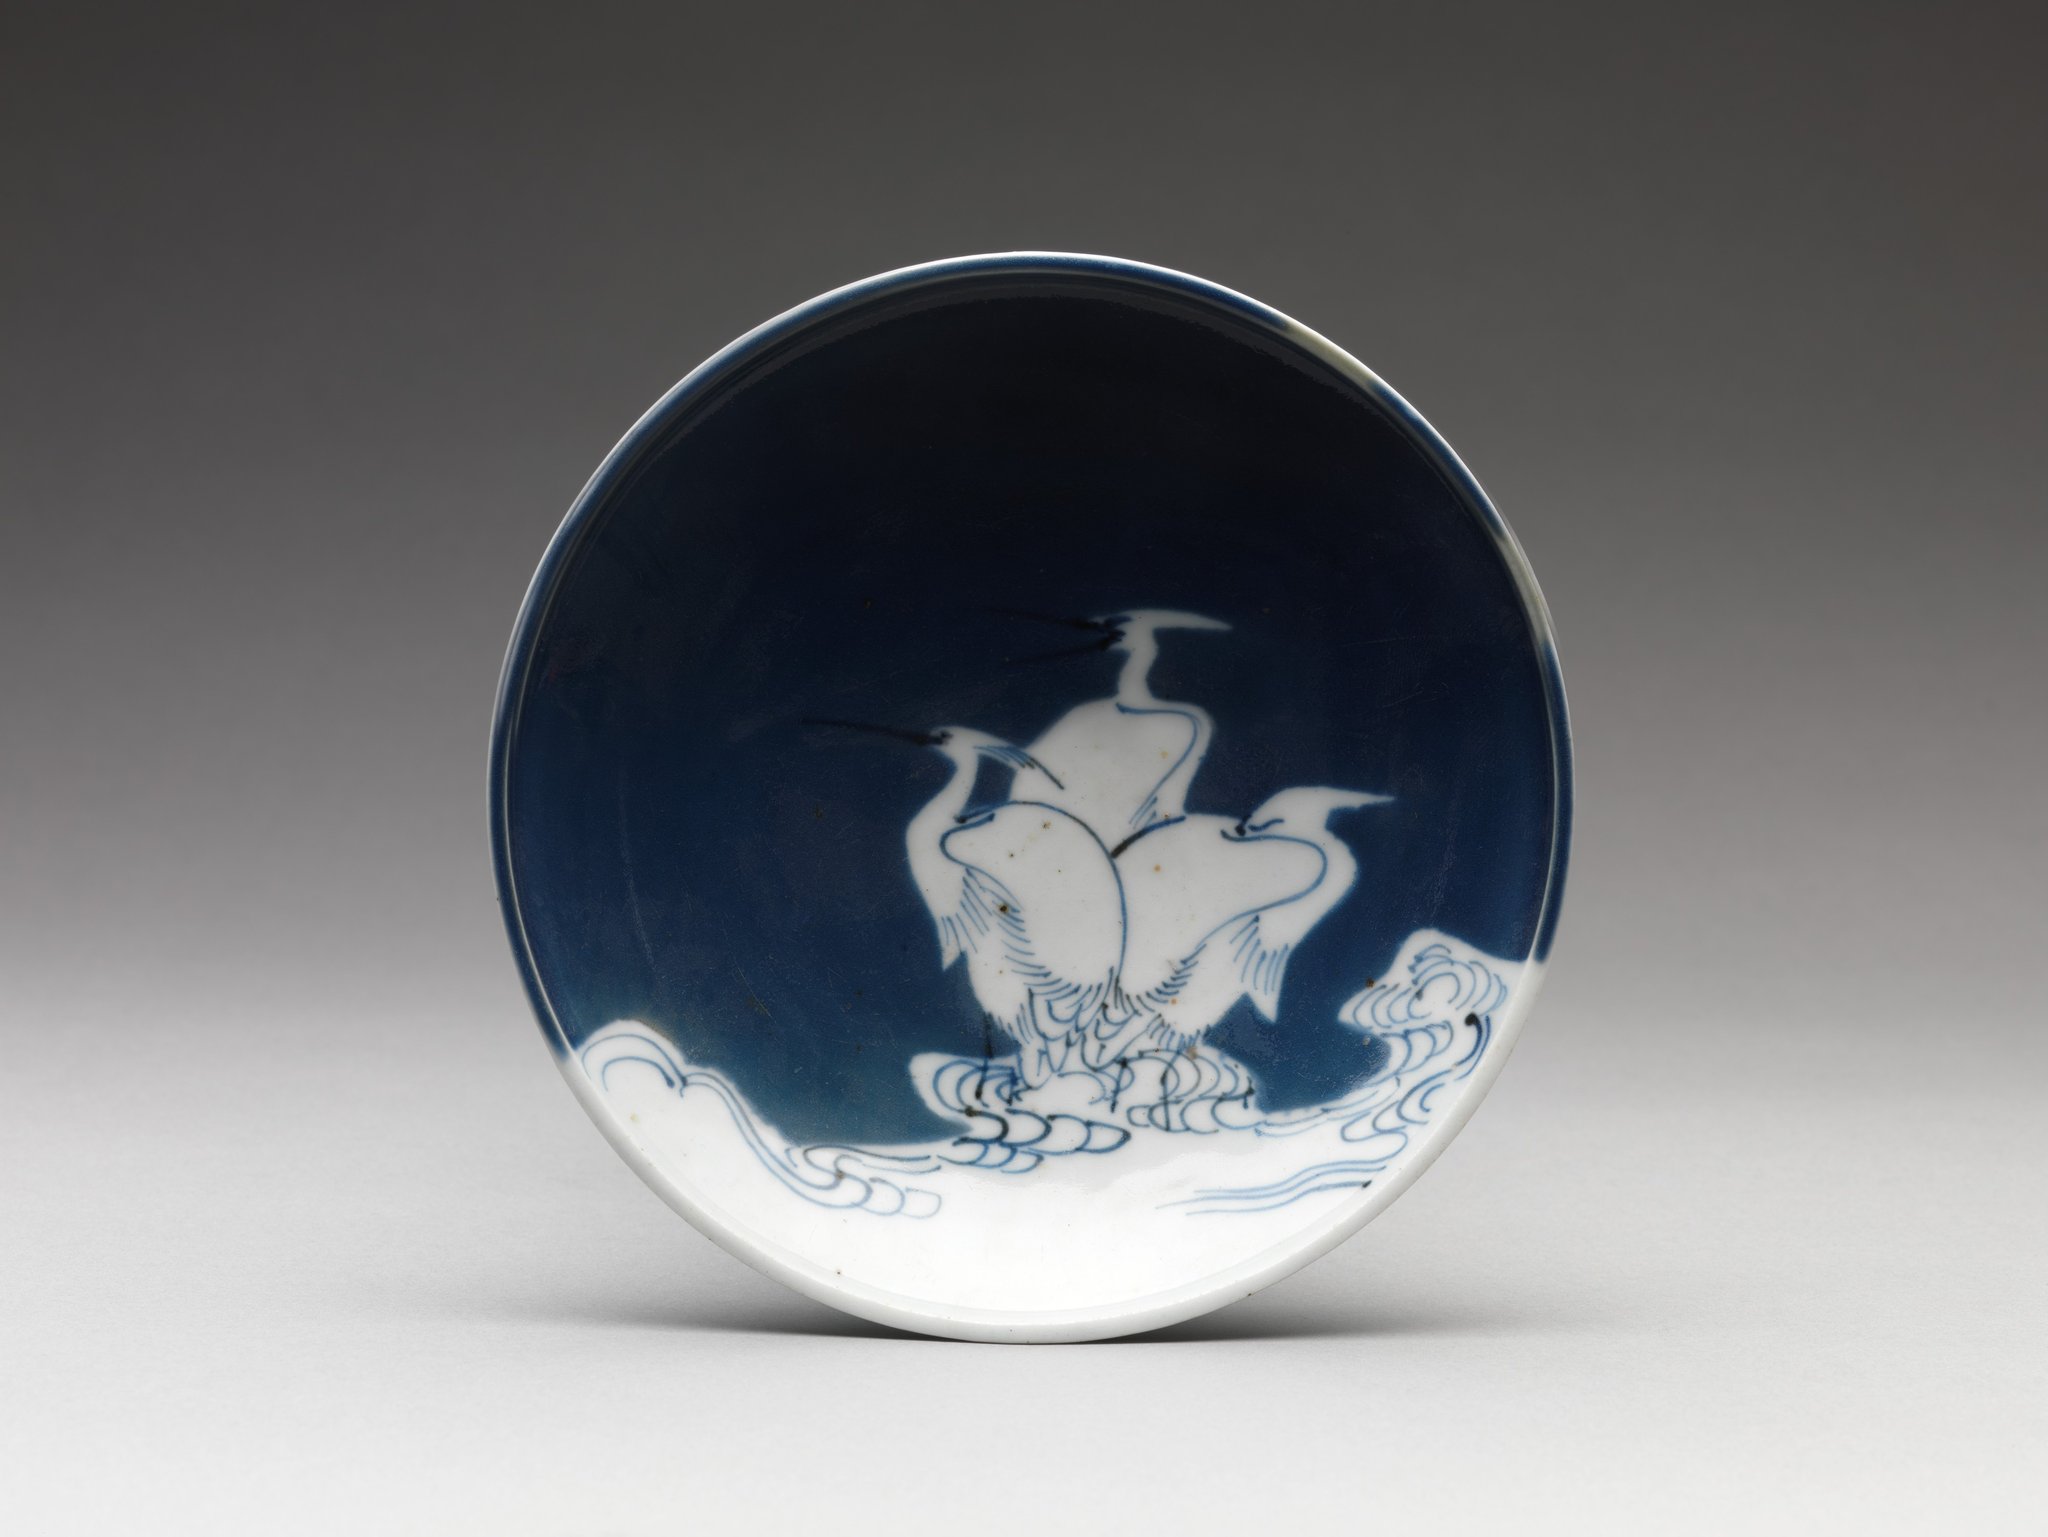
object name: dish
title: Dish with Heron Design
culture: japanese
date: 1667-1700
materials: porcelain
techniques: underglaze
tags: birds